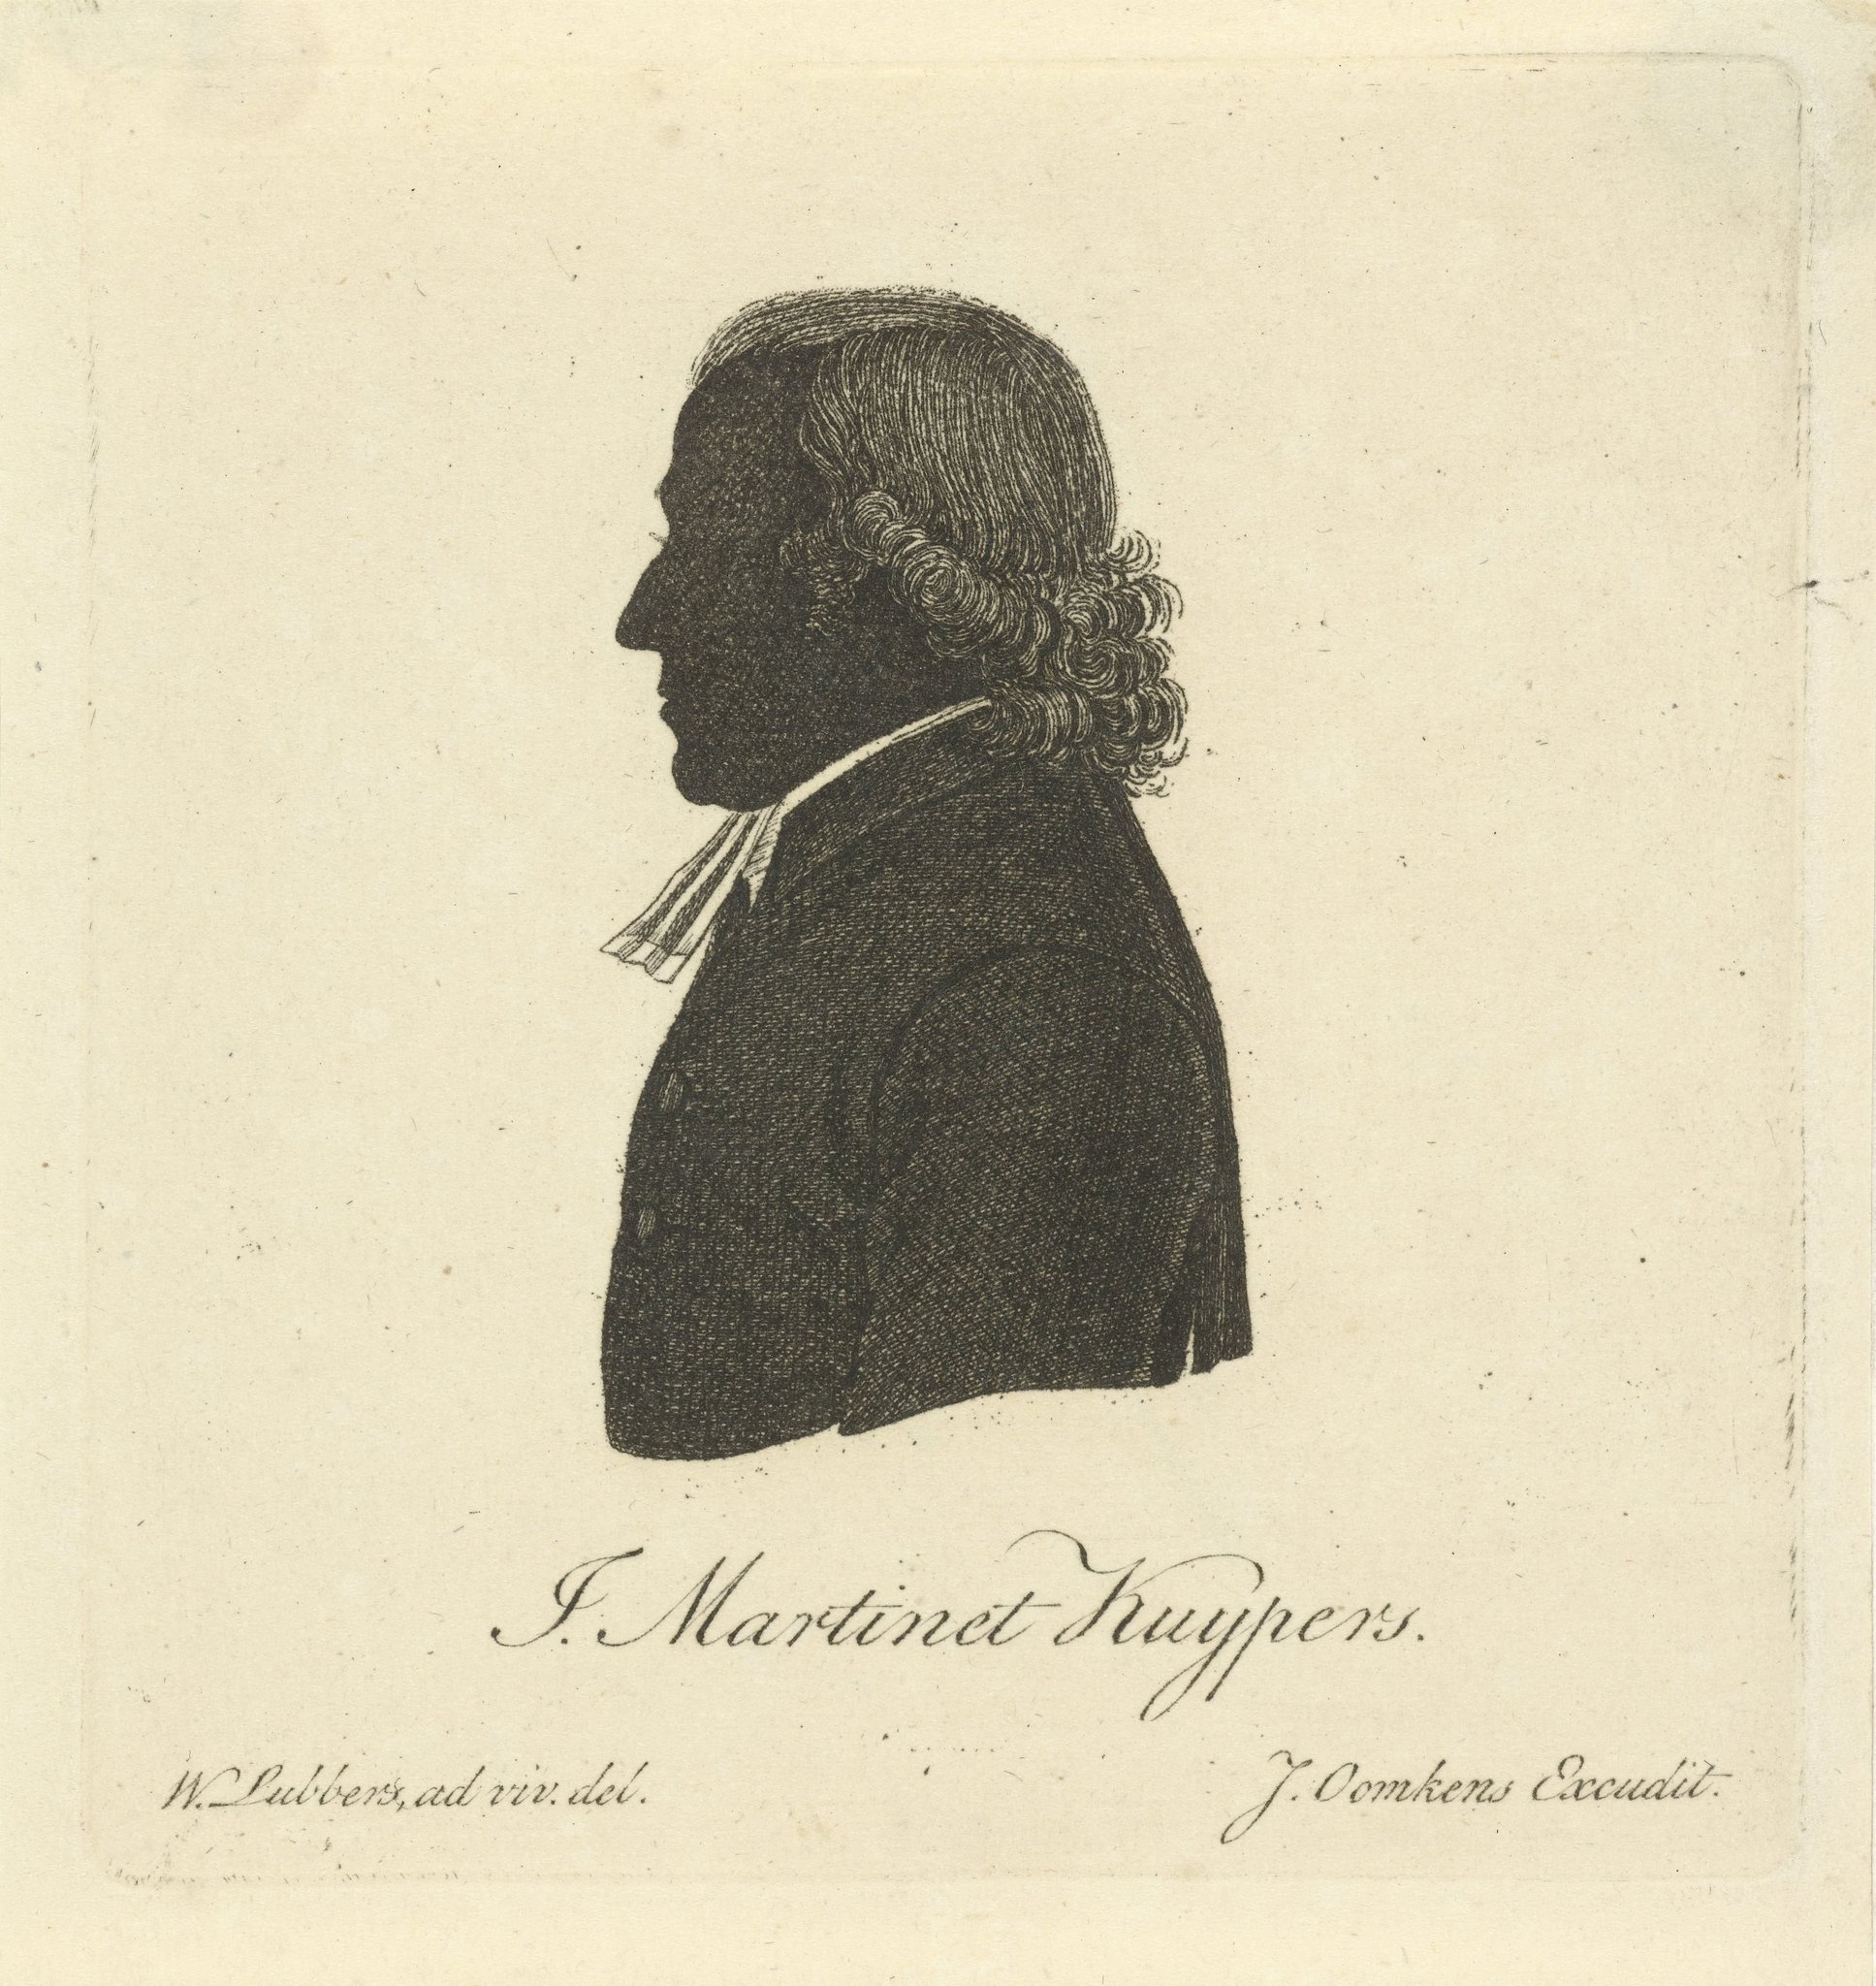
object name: print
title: Silhouetportret van Johannes Martinet Kuijpers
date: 1808-1844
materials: paper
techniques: etching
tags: predikant, johannes martinet kuijpers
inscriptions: collector's mark: Lugt 2228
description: Silhouetportret van Johannes Martinet Kuijpers, buste naar links.